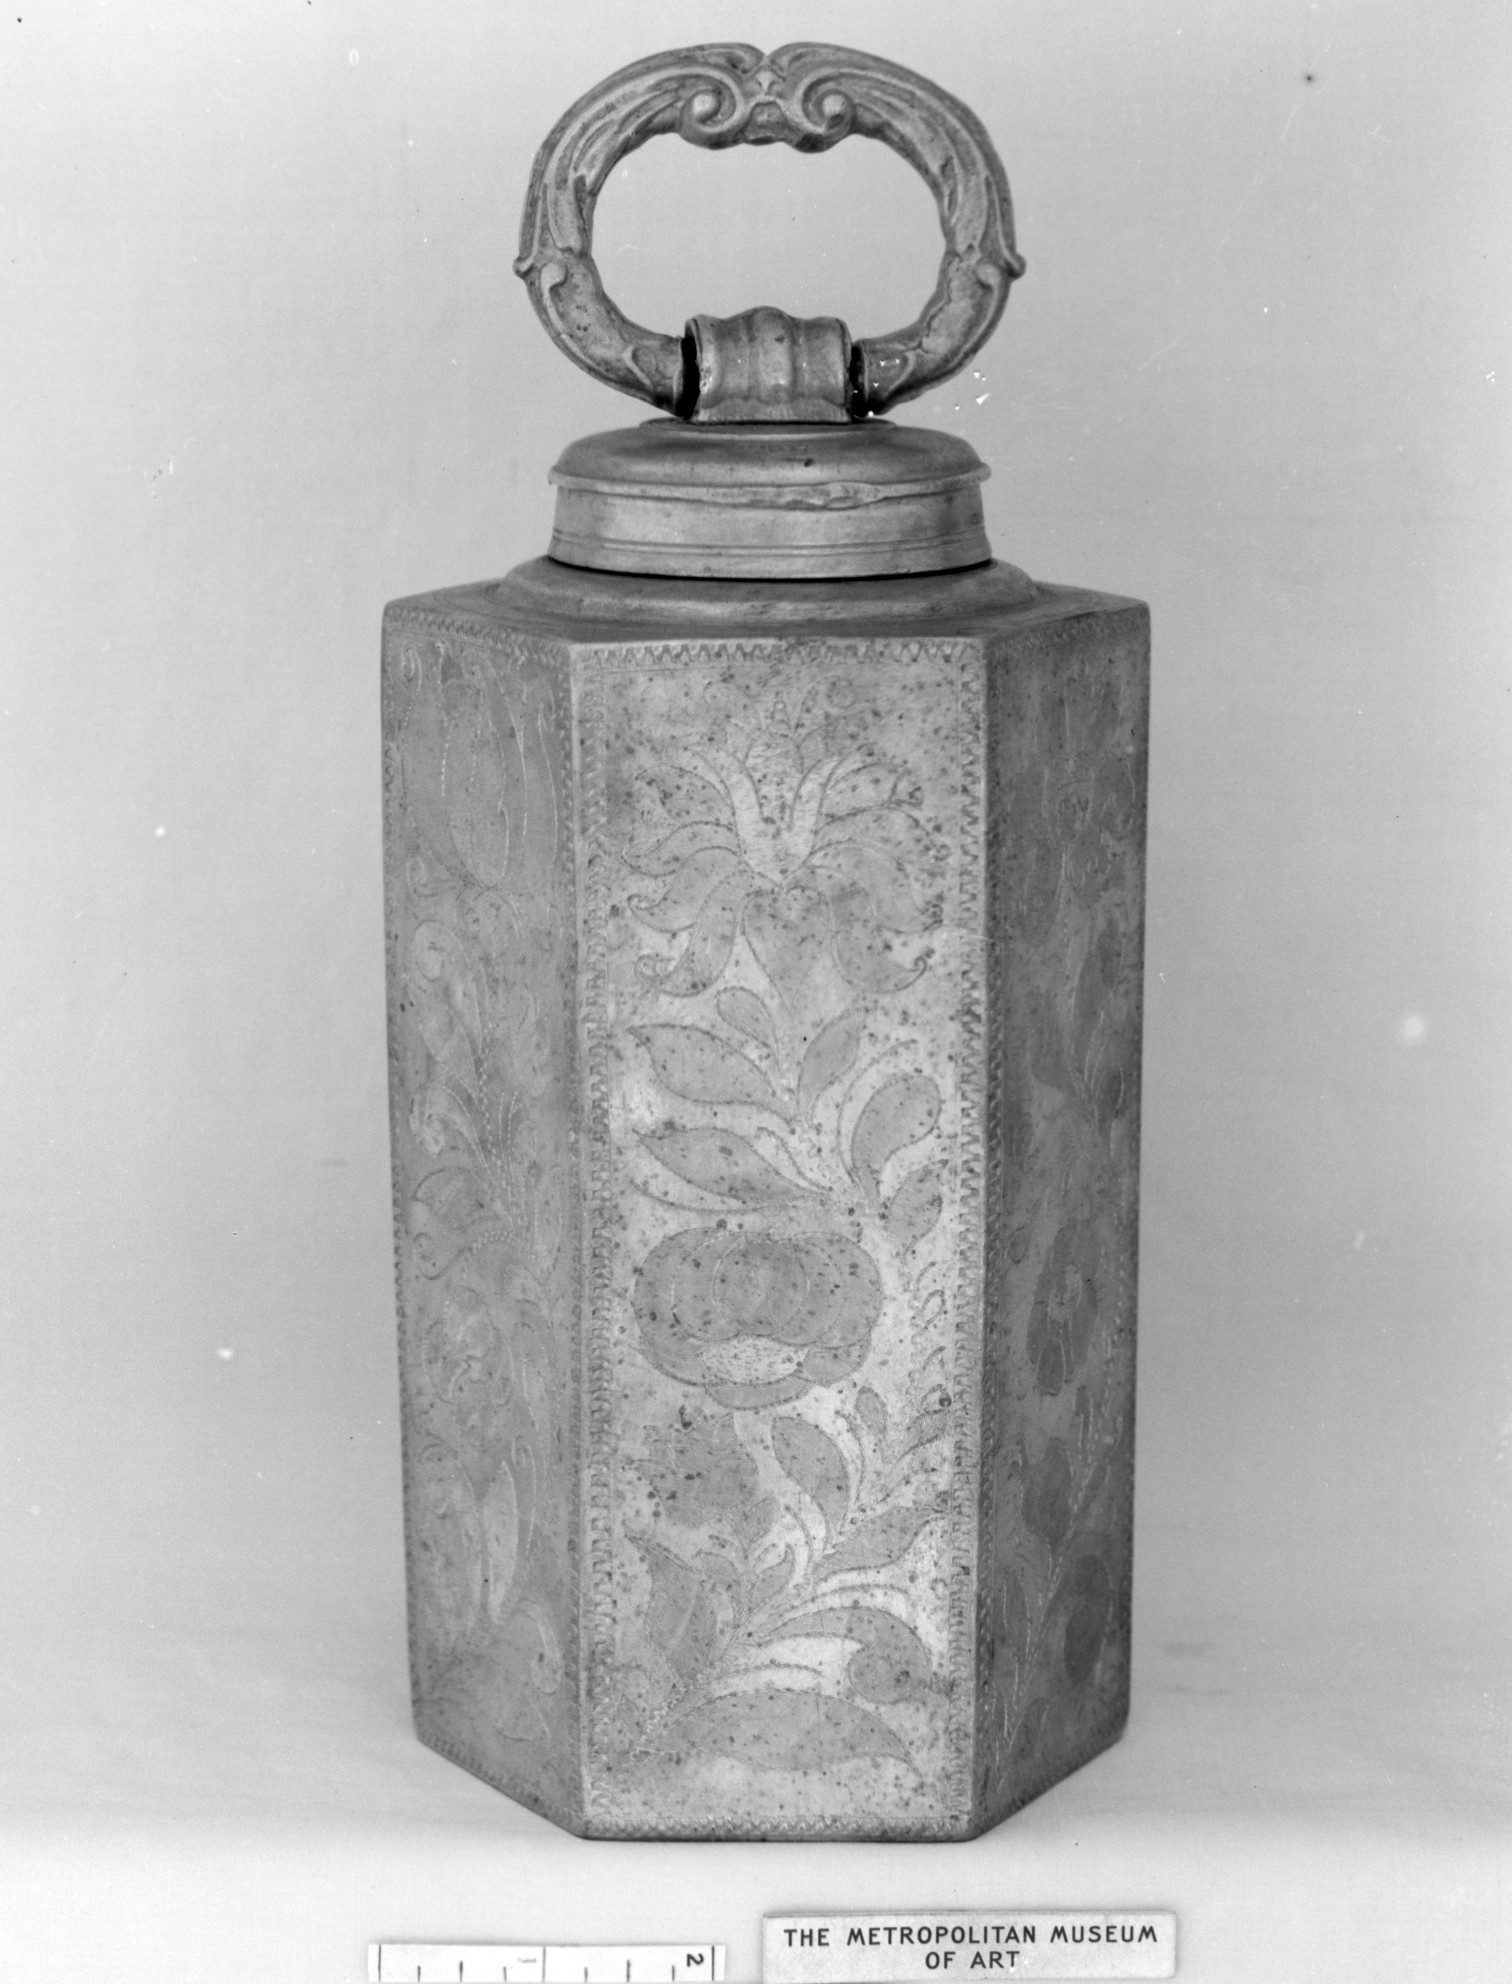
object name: canister or bottle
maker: melchior glatz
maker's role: maker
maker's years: 1656-1716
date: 1667-1700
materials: pewter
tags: flowers